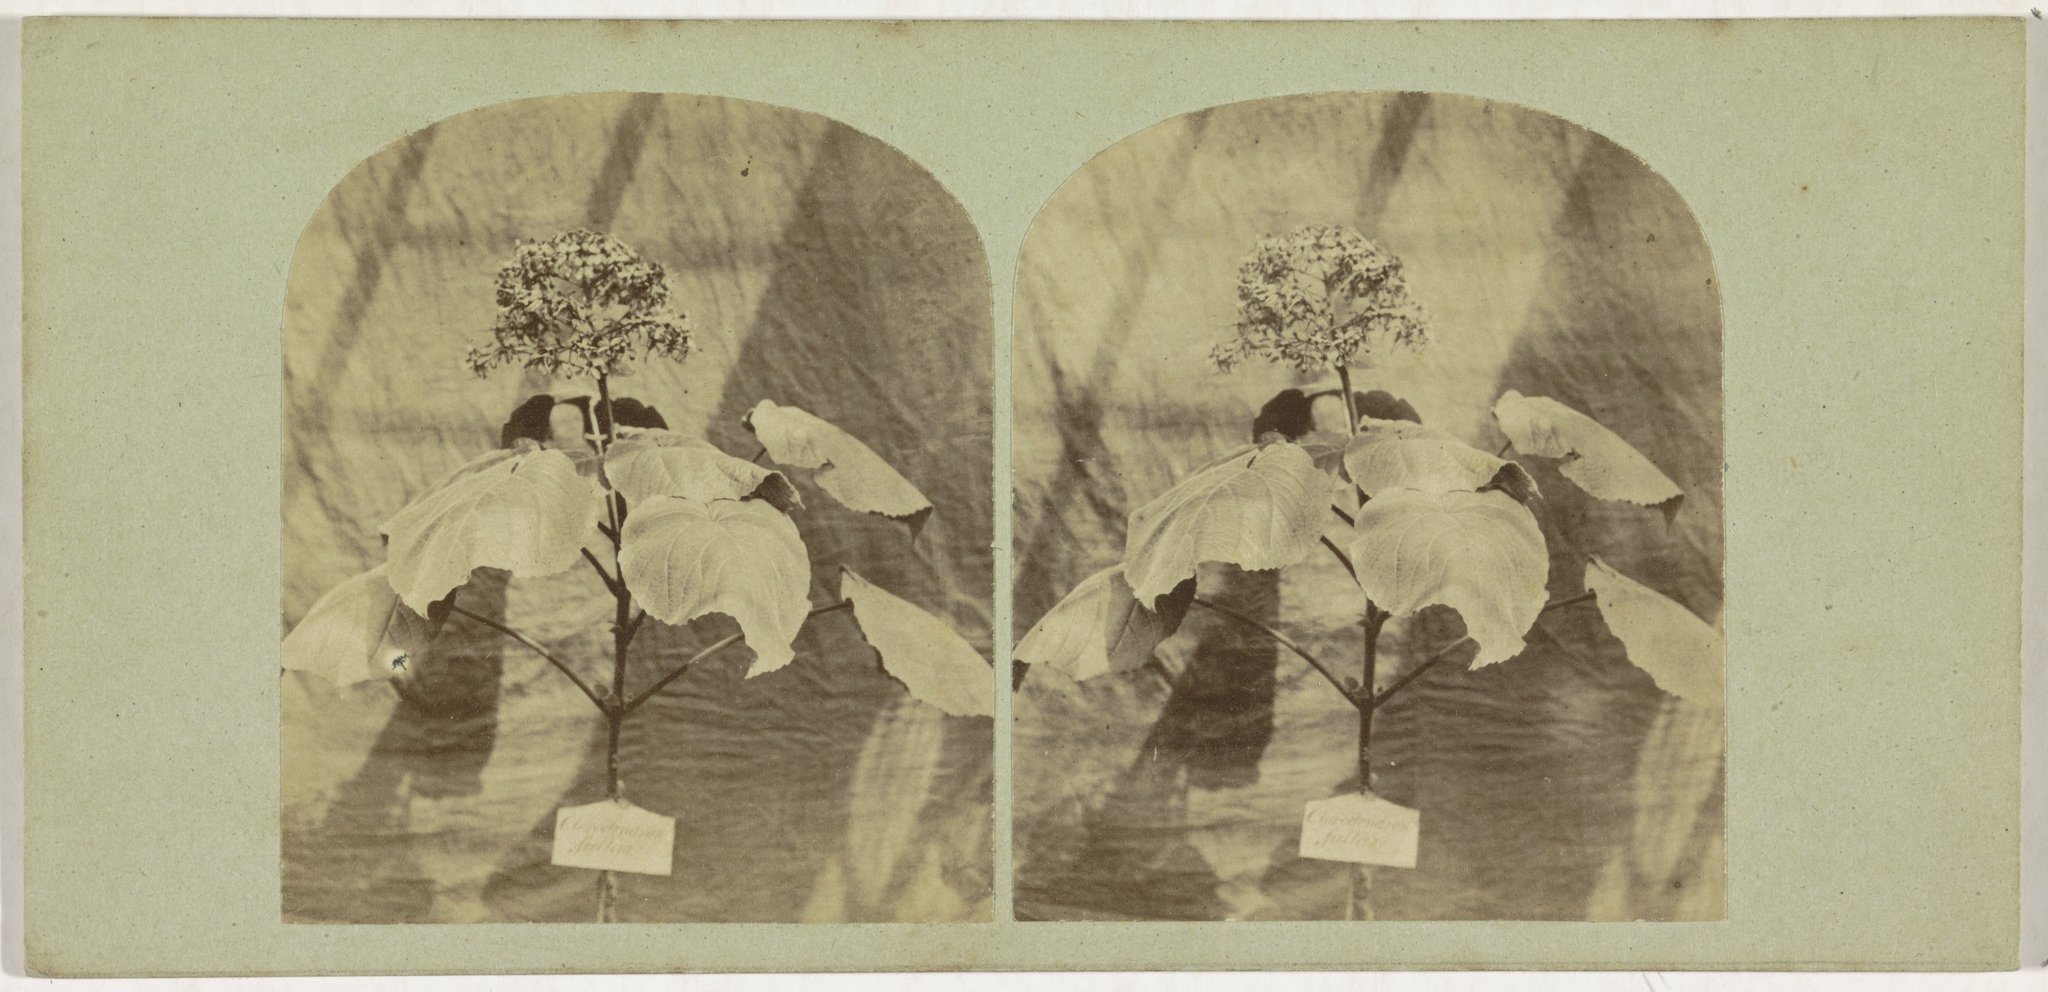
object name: stereograph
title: Plant met bloem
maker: Anonymous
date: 1855-1865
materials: cardboard, paper, photographic support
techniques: albumen print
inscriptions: inscription: ‘bt [?]’, inscription: ‘E5- (?)’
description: Plant met onderaan een kaartje waarop de naam staat (Cler.... fallax?).